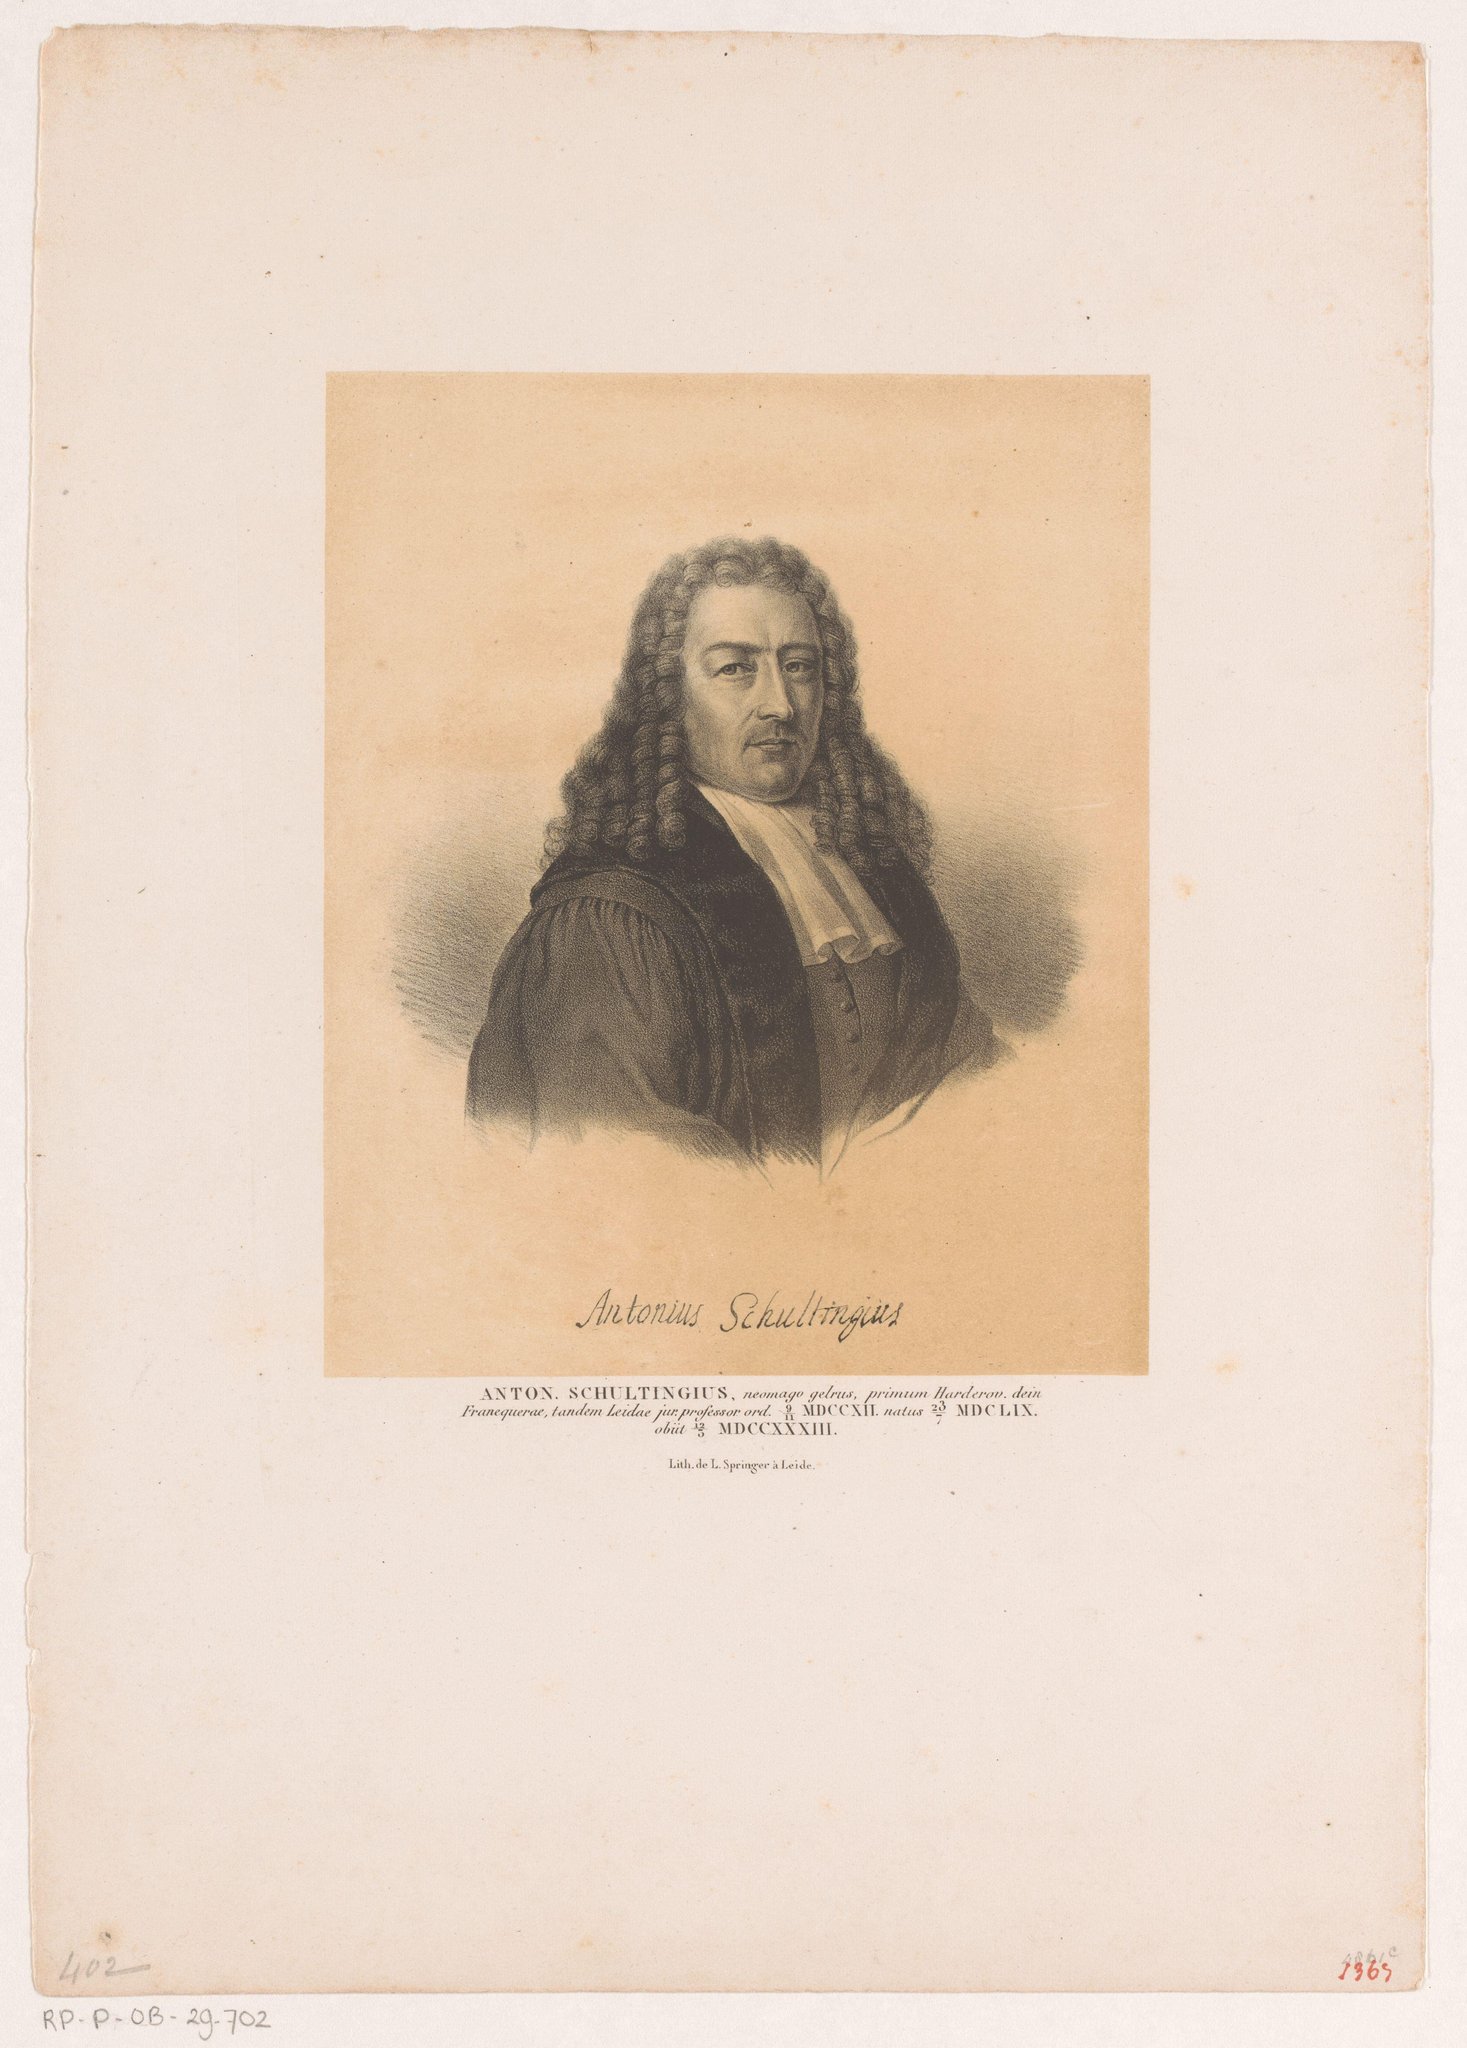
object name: print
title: Portret van Antonius Schultingh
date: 1809-1871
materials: paper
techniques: tone lithography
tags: nijmegen, leiden, historical persons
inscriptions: collector's mark: Lugt 2228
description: Onder het portret de signatuur en biografische gegevens van de geportretteerde.